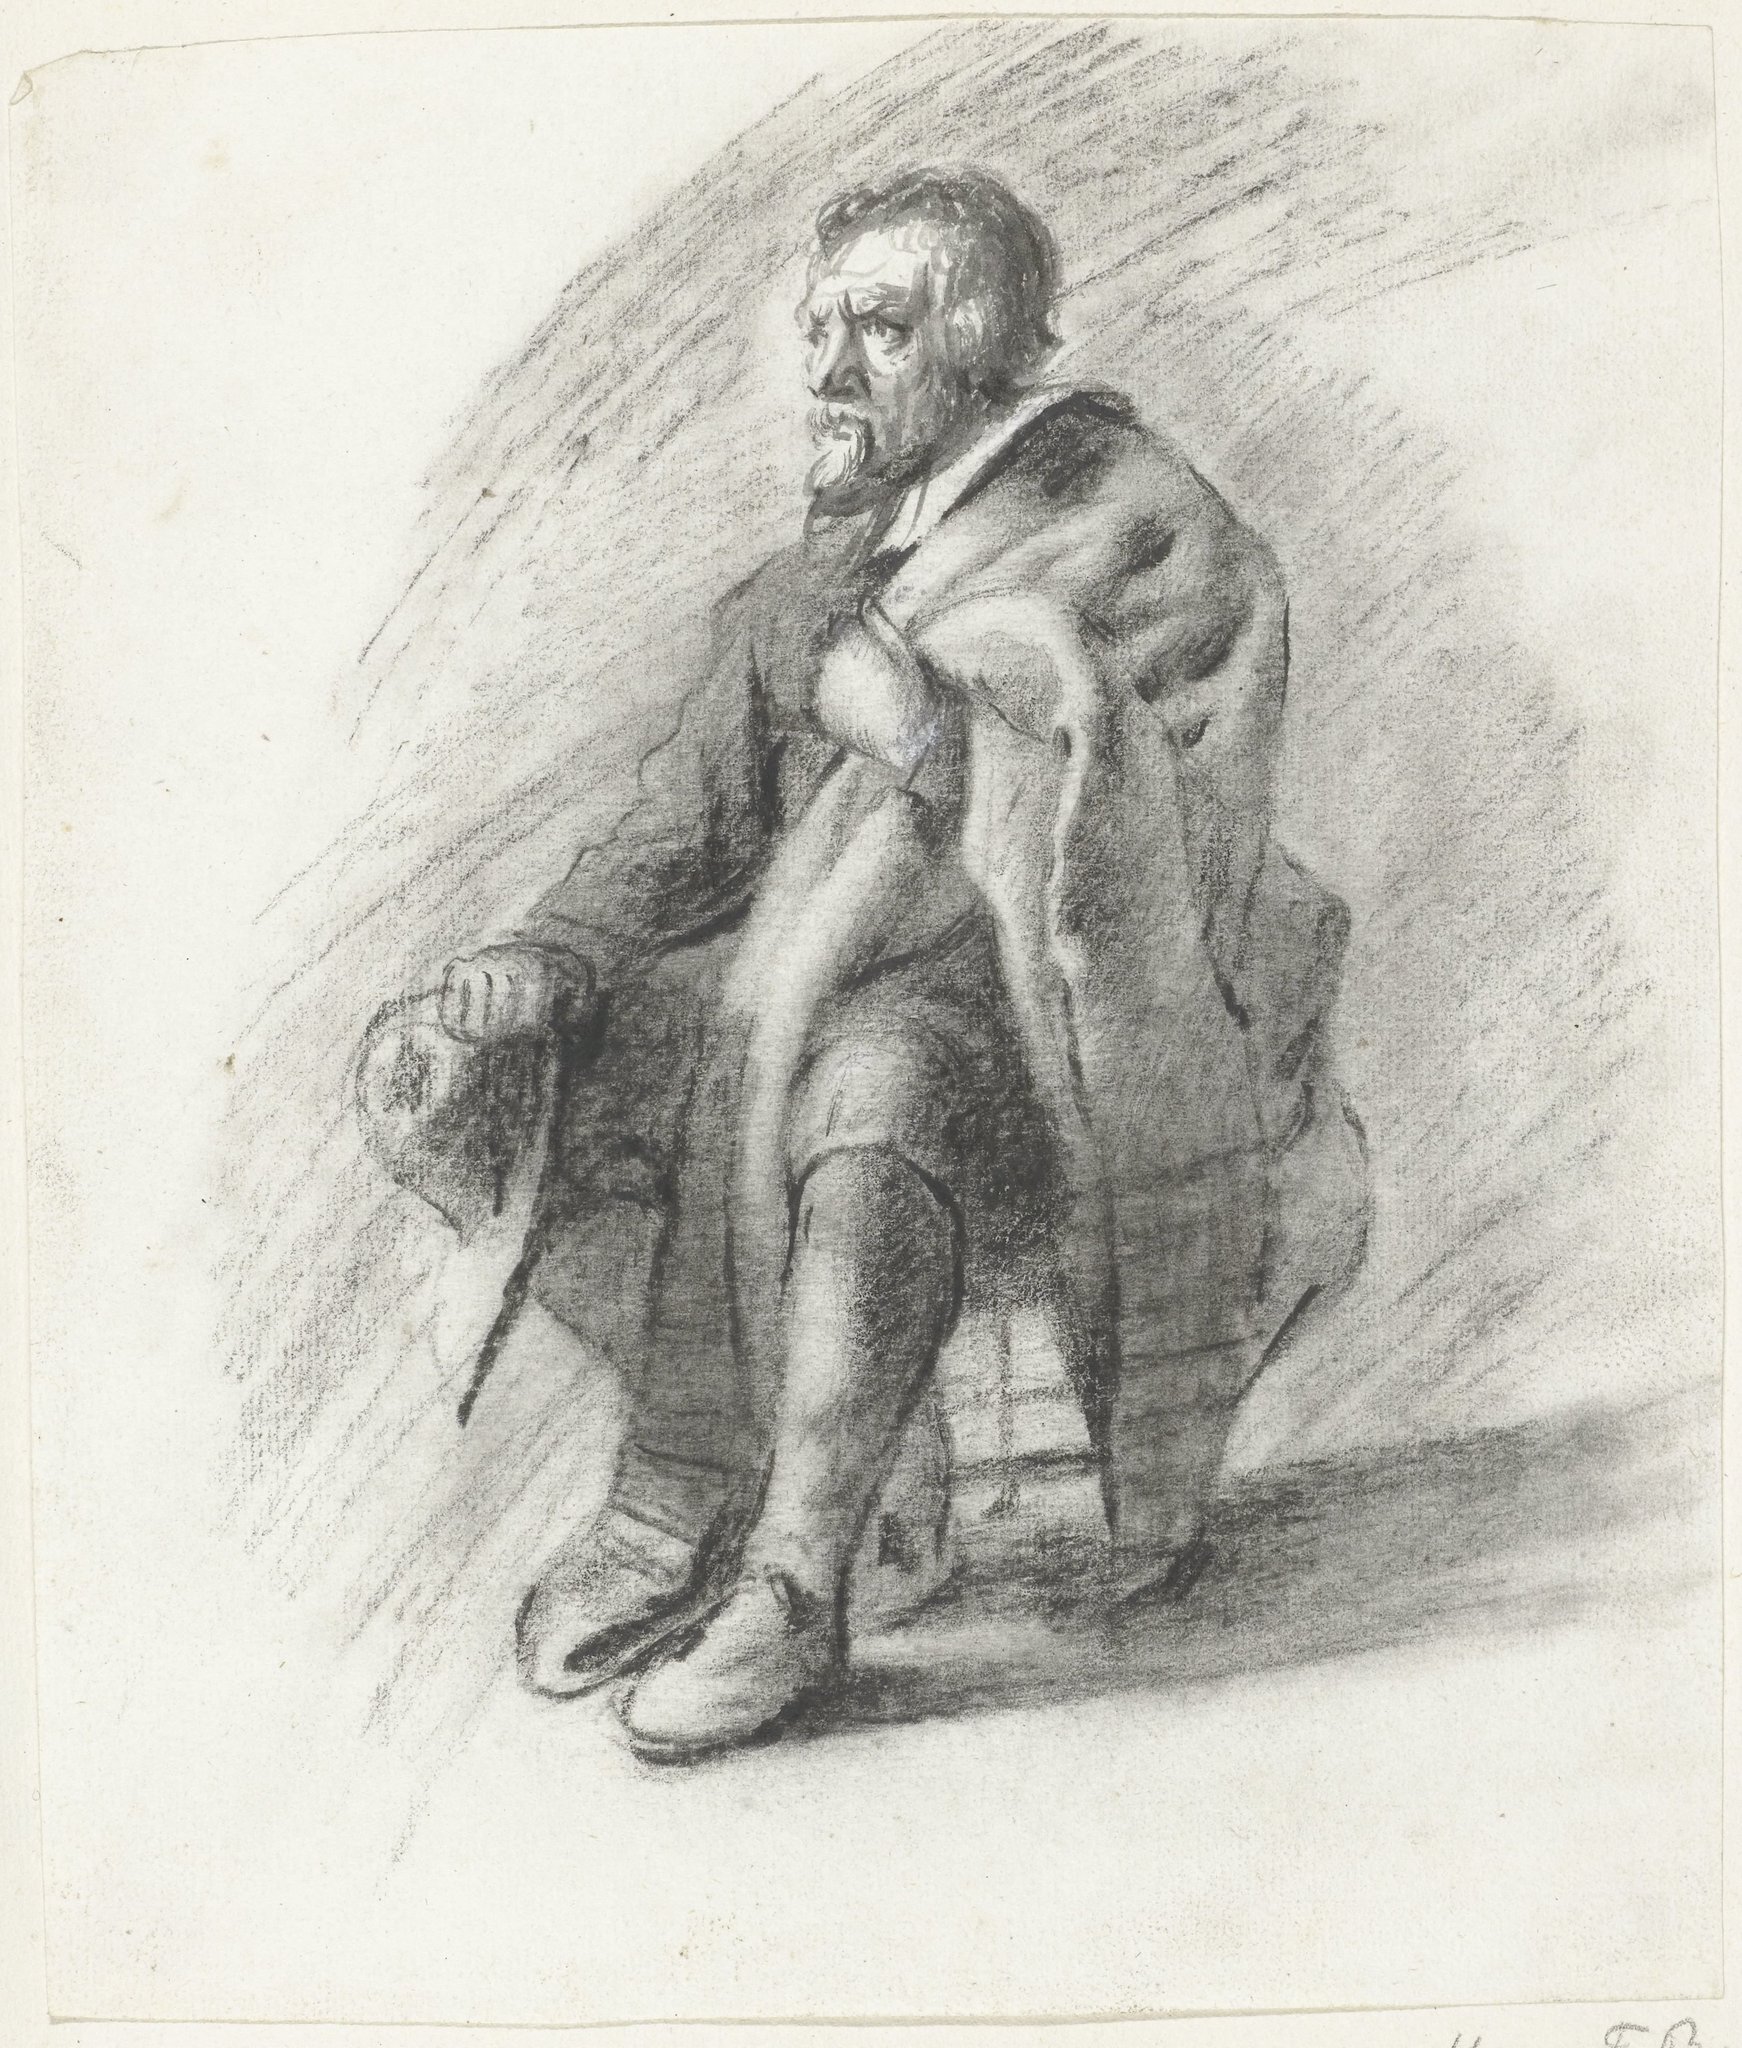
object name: drawing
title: Zittende bebaarde man met cape en hoed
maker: moses ter borch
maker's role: draughtsman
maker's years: 1645-1667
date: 1655-1667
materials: chalk, paper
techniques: brush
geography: zwolle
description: Tekening naast een andere tekening geplakt in het Familie-plakboek.